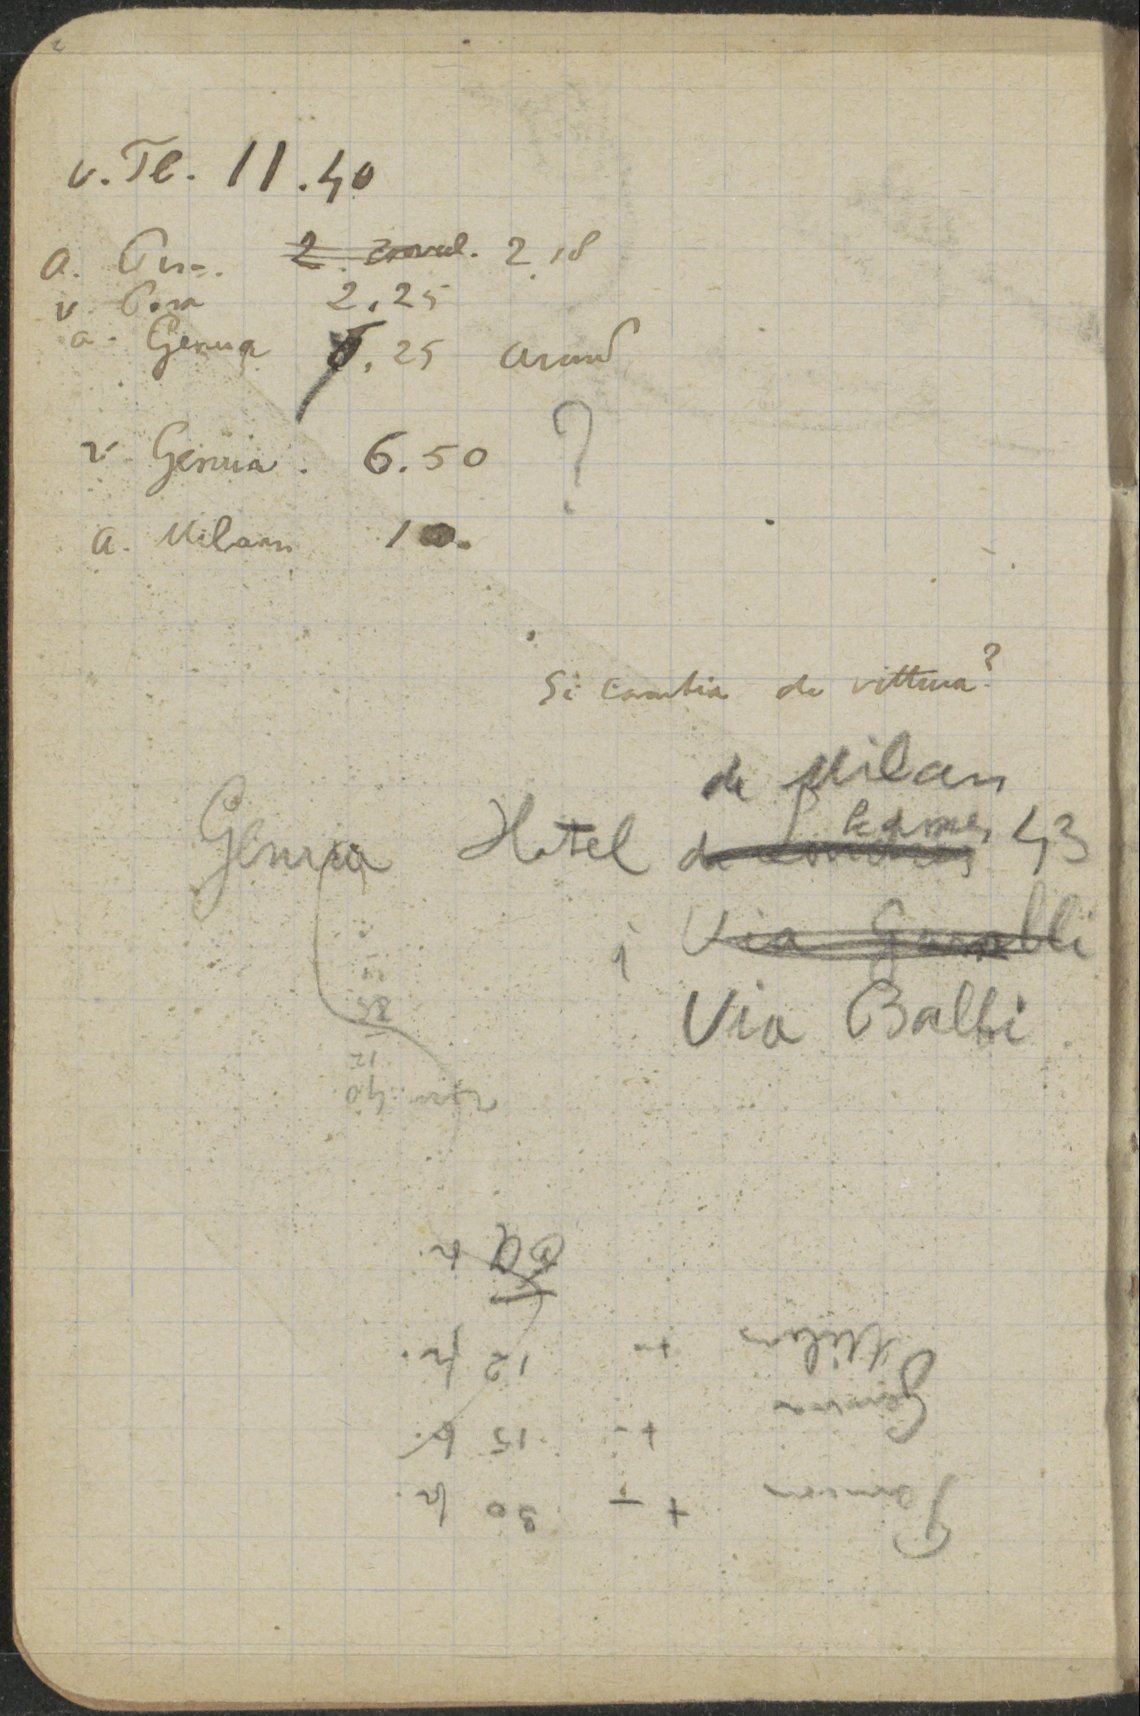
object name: sketchbook leaf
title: Reisnotities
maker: marius bauer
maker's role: draughtsman, print maker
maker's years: 1867-1932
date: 1895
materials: chalk, ink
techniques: pen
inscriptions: annotation: ‘v. Te. 11.40/ [...]/ a. Genua [...]/ a. Milan/ si cambia de vittura/ Genua Hotel/ de Milan [...] Via Balli [...]’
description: Pagina 2 uit een schetsboek met 28 bladen.